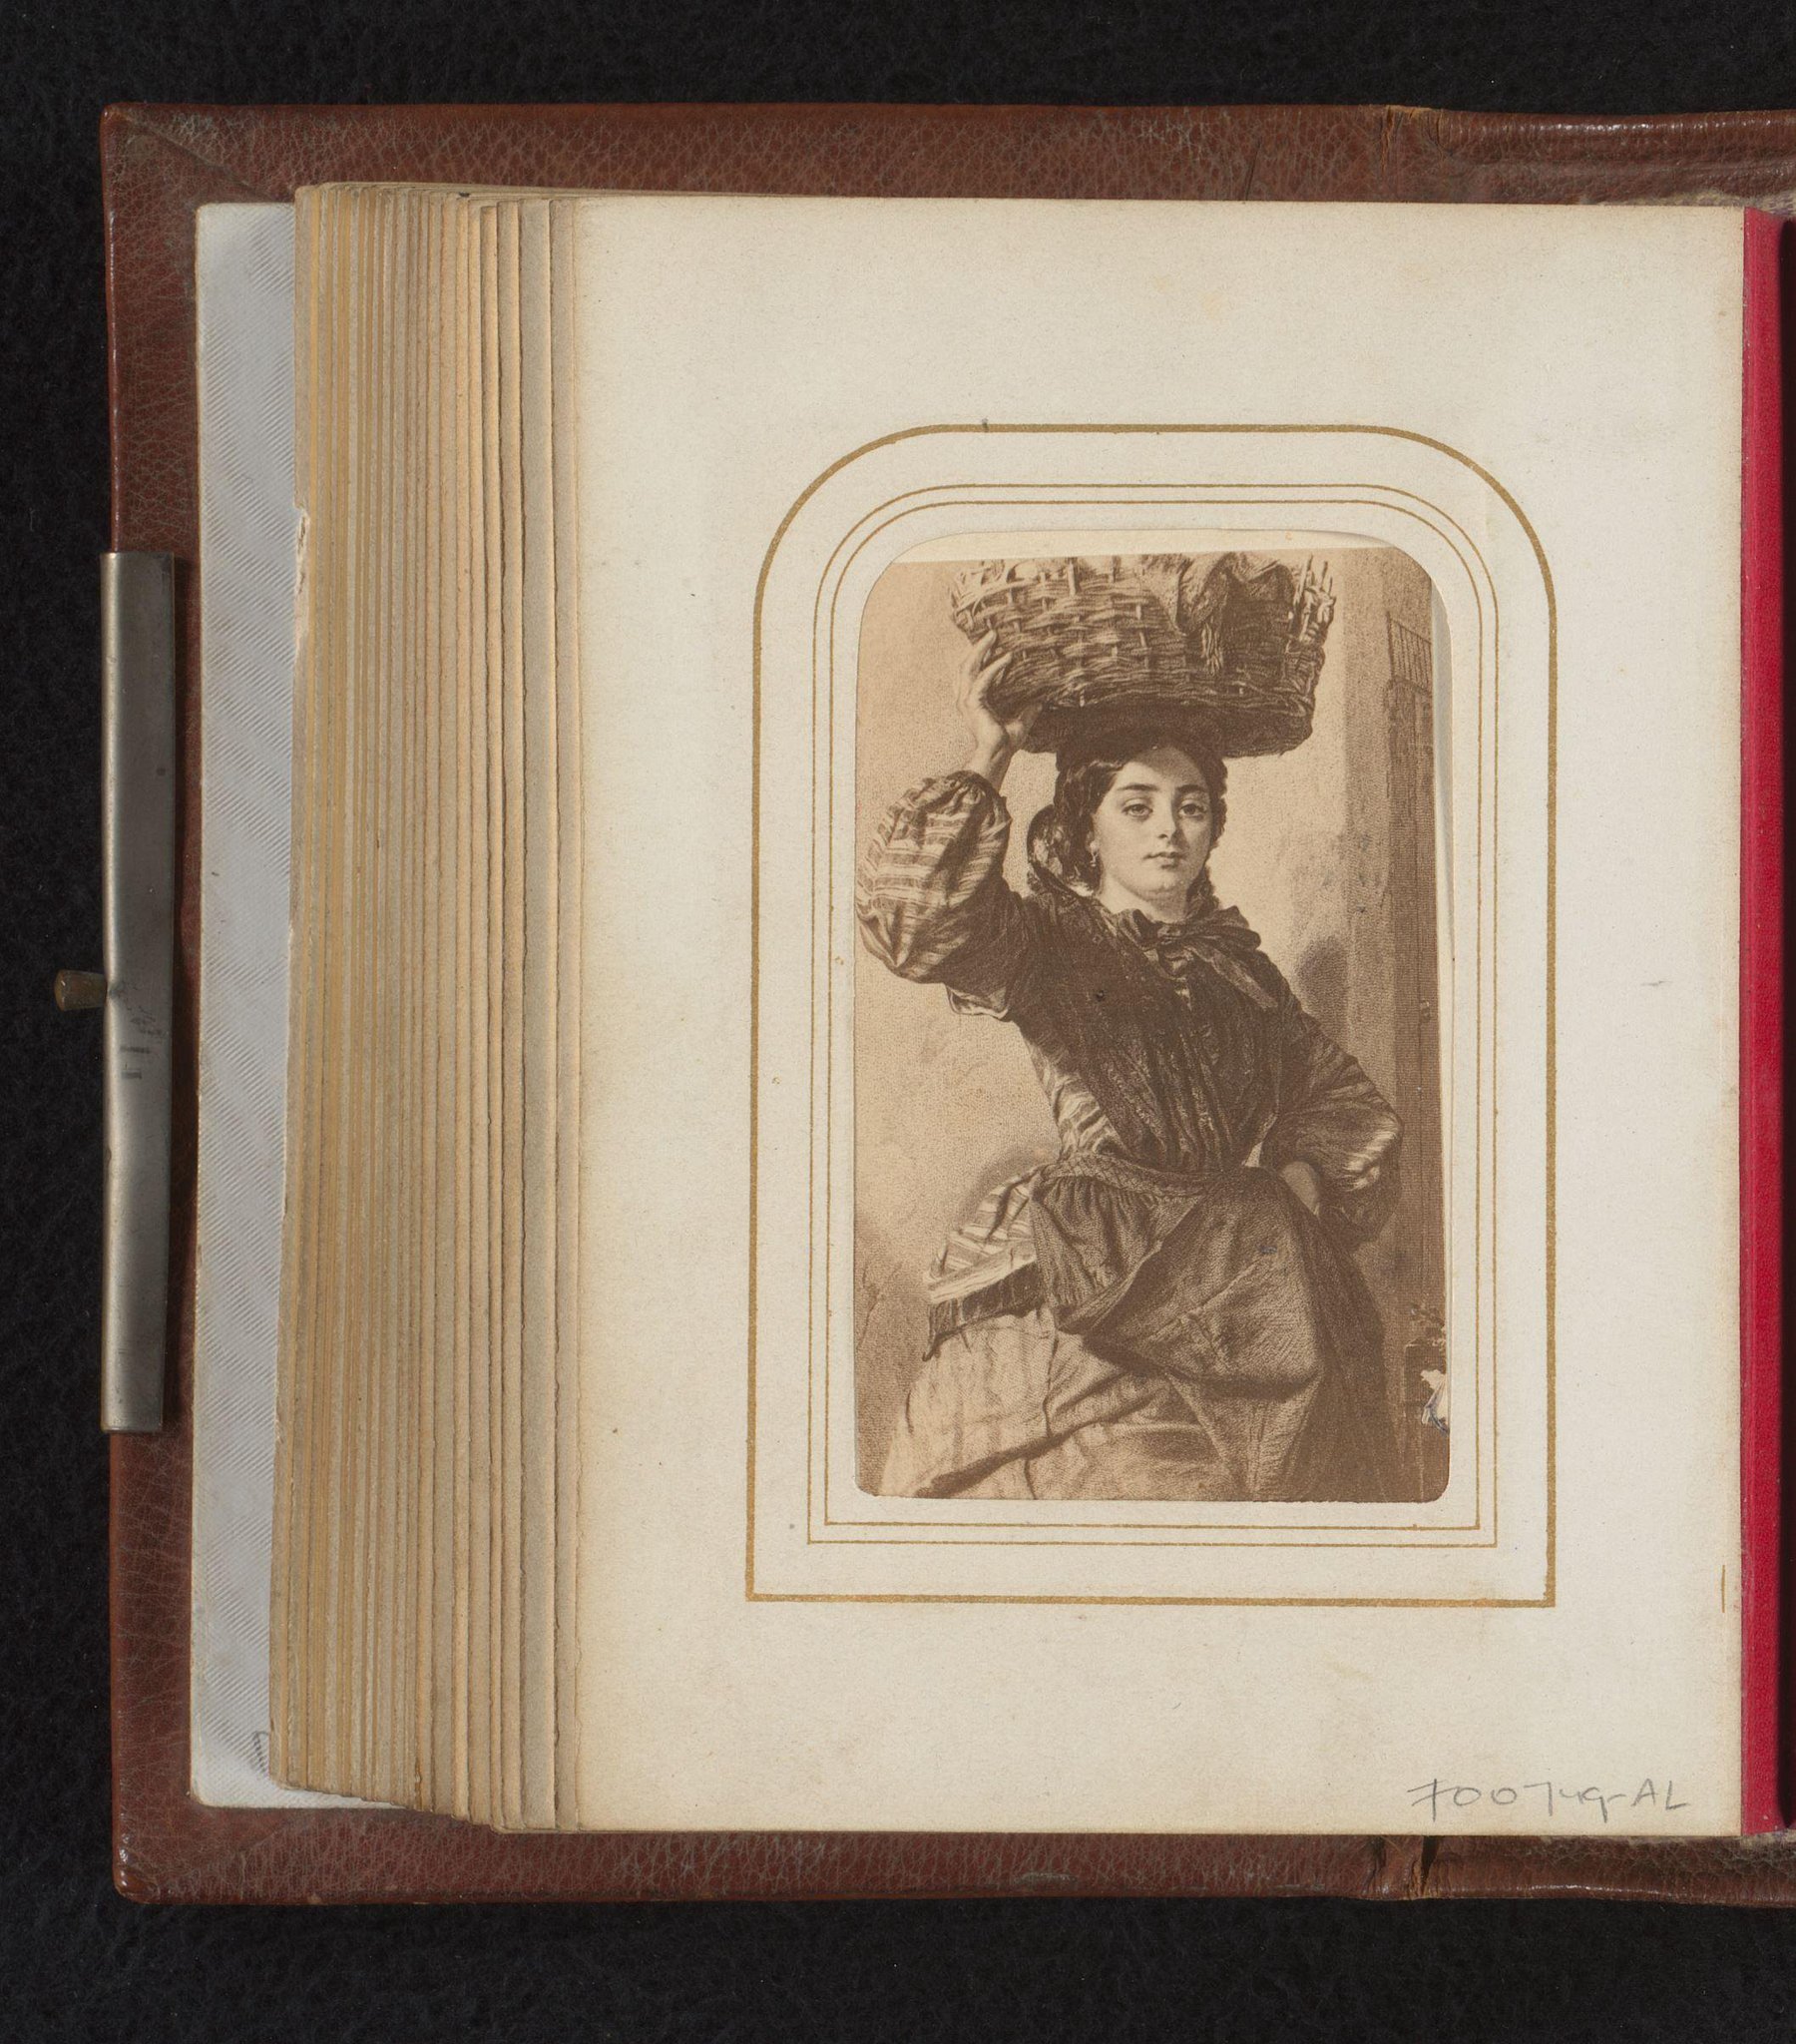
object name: album leaf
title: Fotoreproductie van prent naar een schilderij met een meisje met een mand op haar hoofd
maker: Anonymous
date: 1865-1900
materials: cardboard, photographic support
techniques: albumen print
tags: container made of plant material other than wood: basket, girl (child between toddler and youth)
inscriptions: inscription: ‘156/ La fille aux oranges/ Das orangenmadchen/ The orange girl’